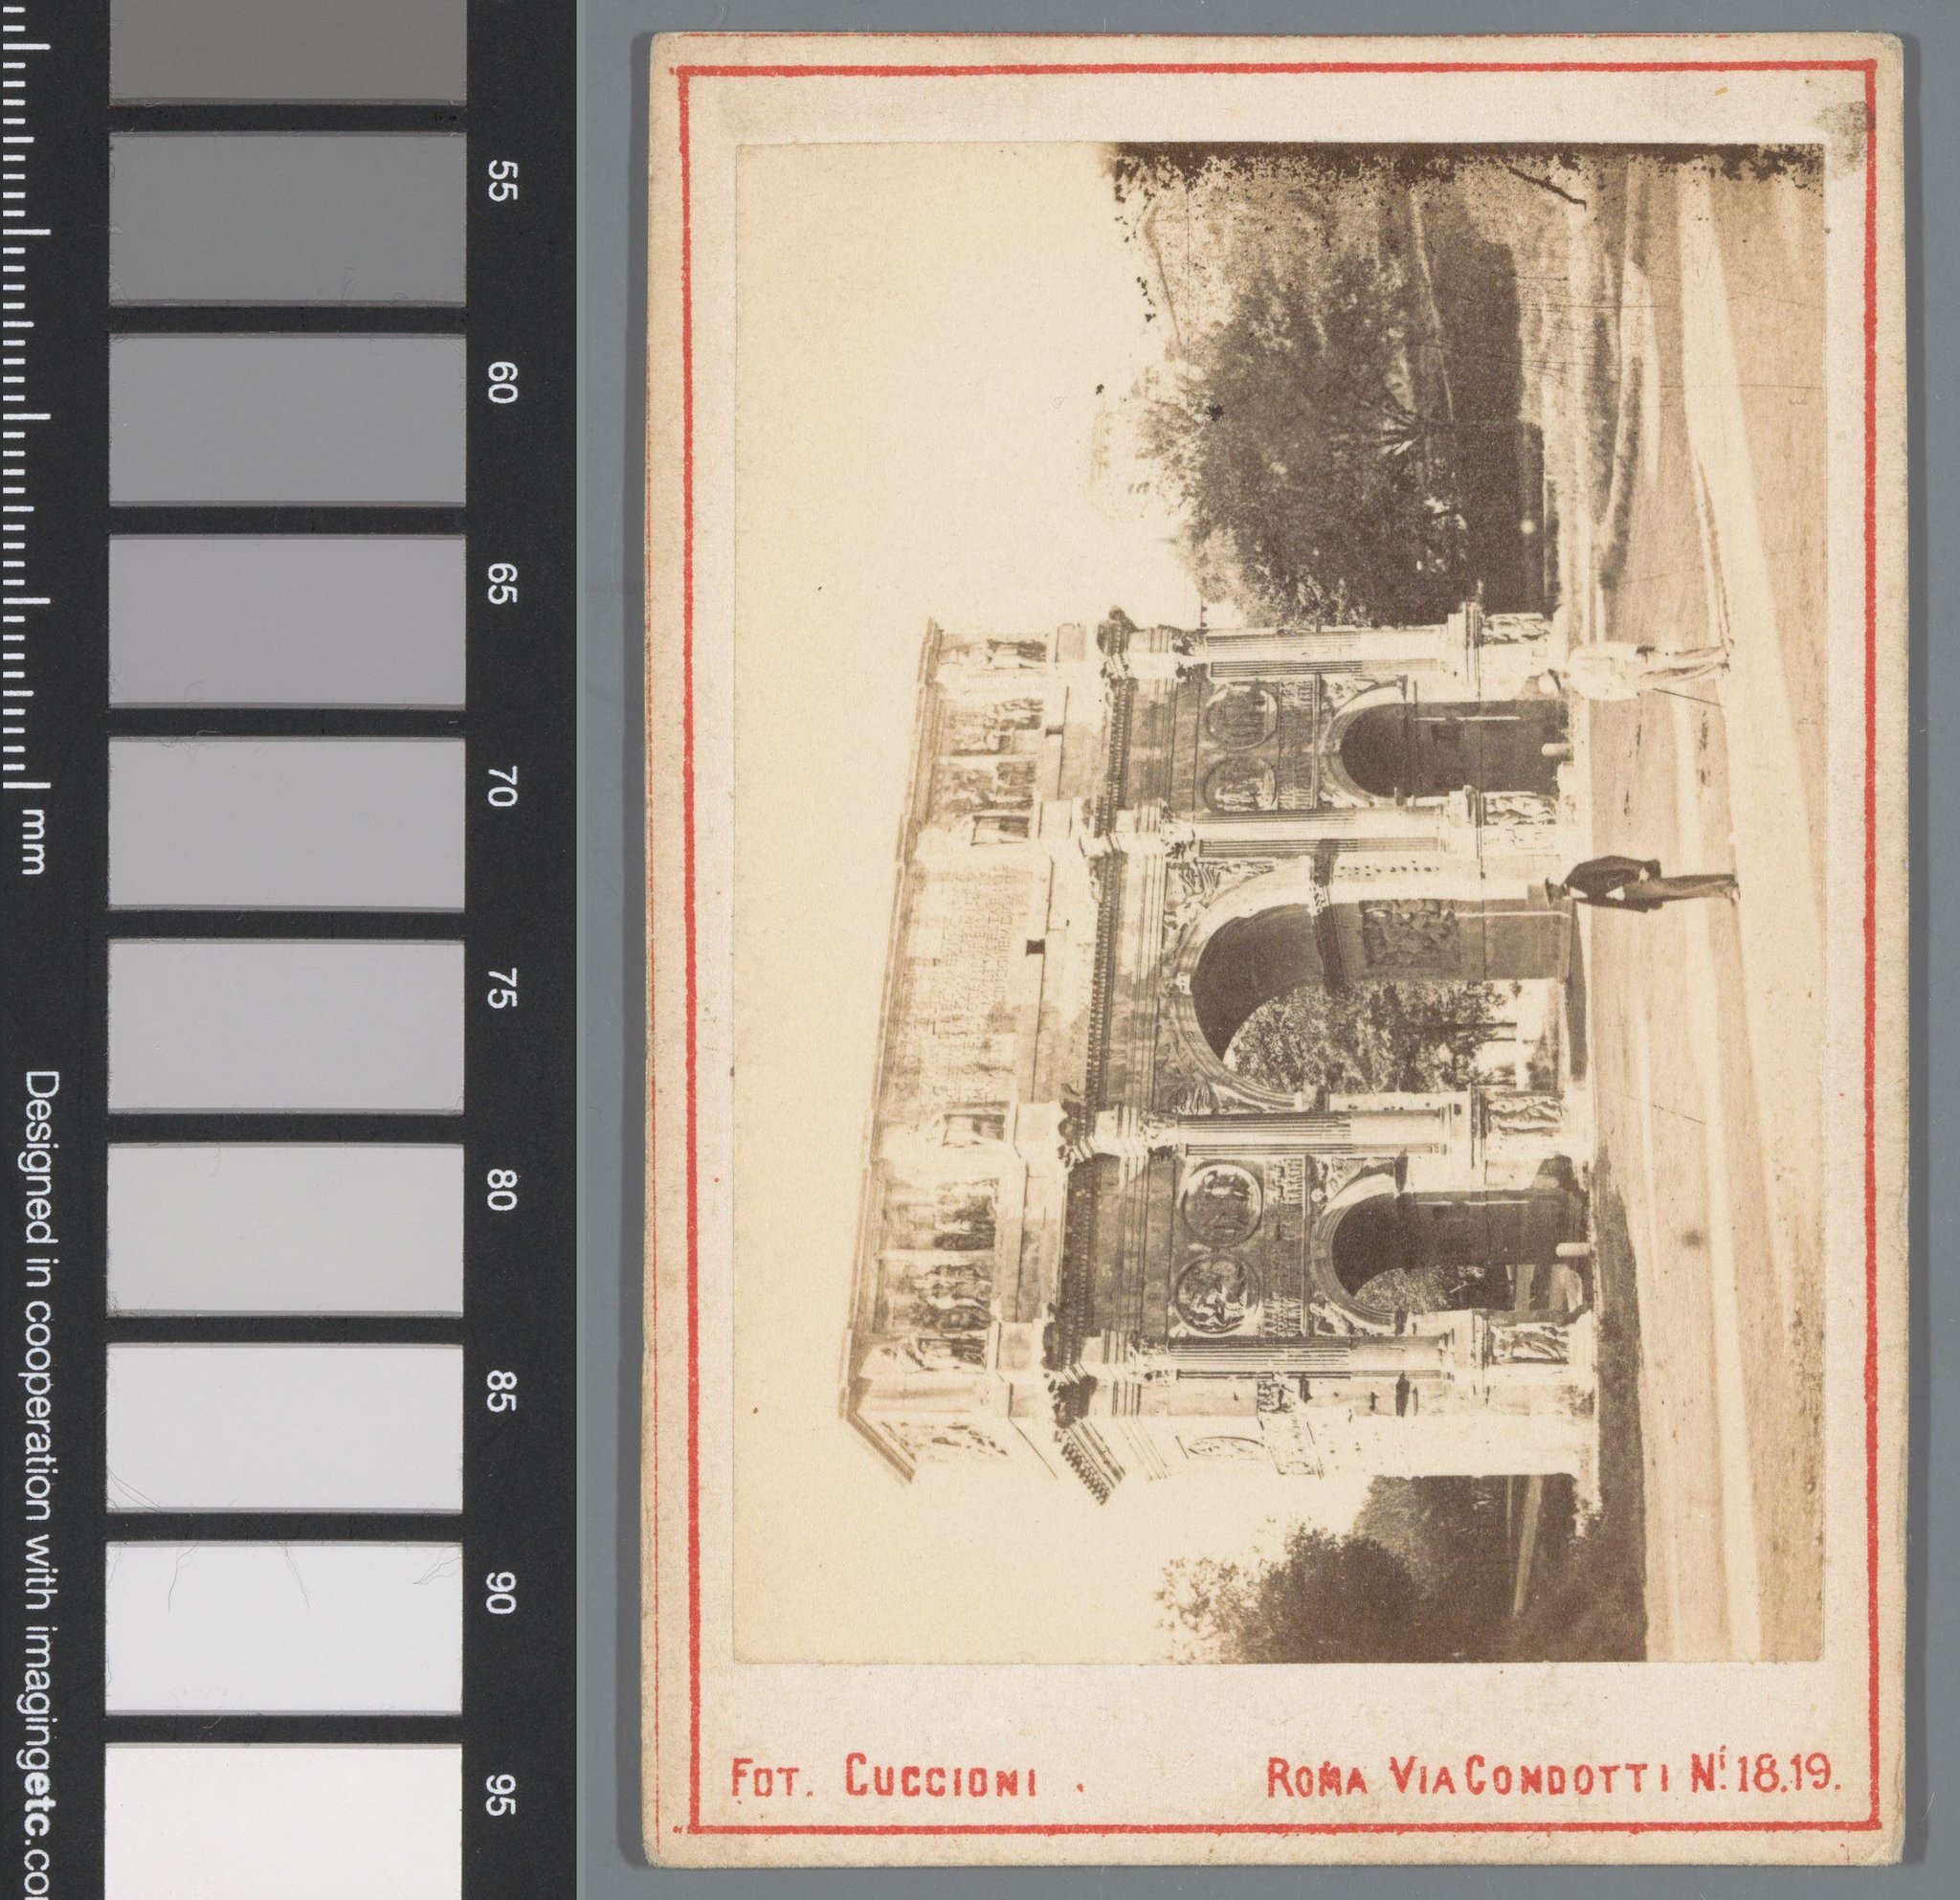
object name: photograph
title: Boog van Constantijn, Rome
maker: tomasso cuccioni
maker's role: print maker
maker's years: 1790-1864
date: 1855-1885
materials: cardboard, paper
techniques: albumen print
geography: rome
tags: triumphal arch, arch of constantine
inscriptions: inscription: ‘Roma Via Condotti Ni. 18.19.’, inscription: ‘Arc de Constantin’